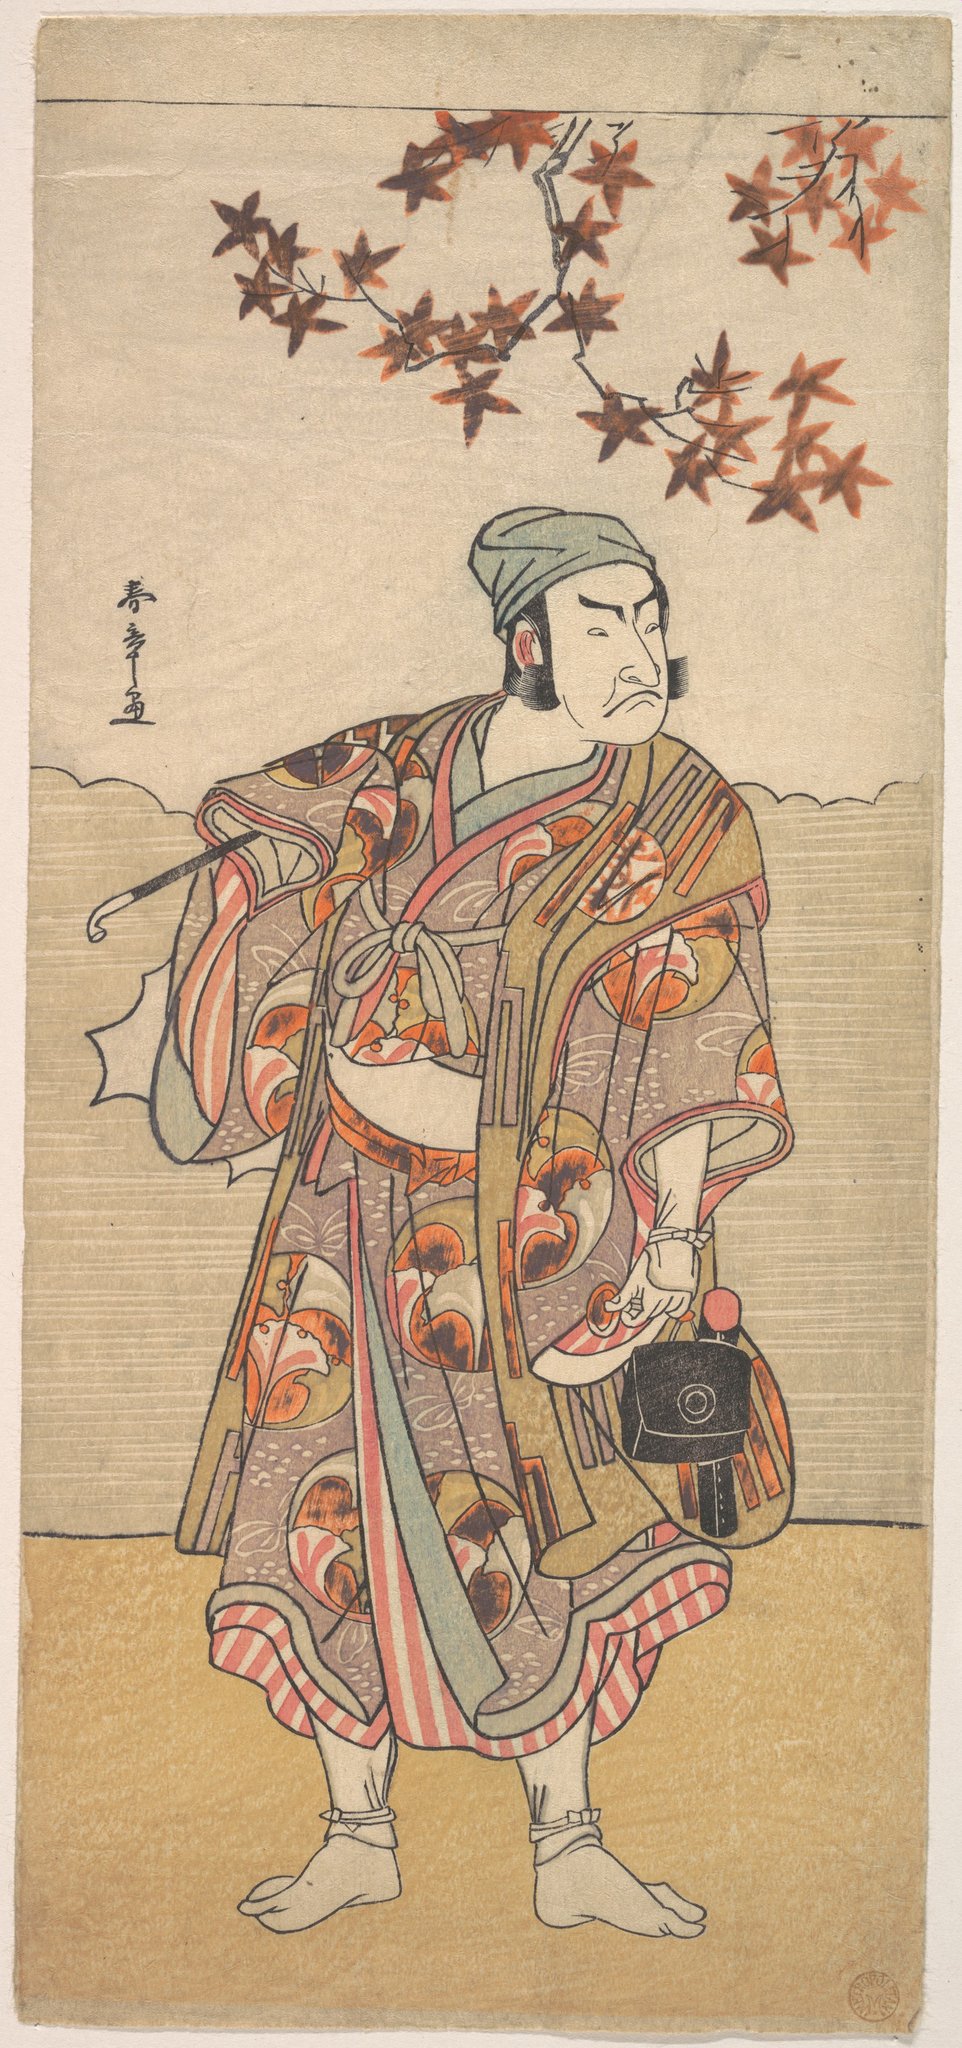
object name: woodblock print nishiki e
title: The First Nakamura Nakazō in the Role of Shimada no Hachizō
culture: japanese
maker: katsukawa shunshō 勝川春章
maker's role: artist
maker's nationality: japanese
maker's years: 1726-1792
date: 1783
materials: ink, paper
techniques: nishiki e, woodblock print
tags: men,actors